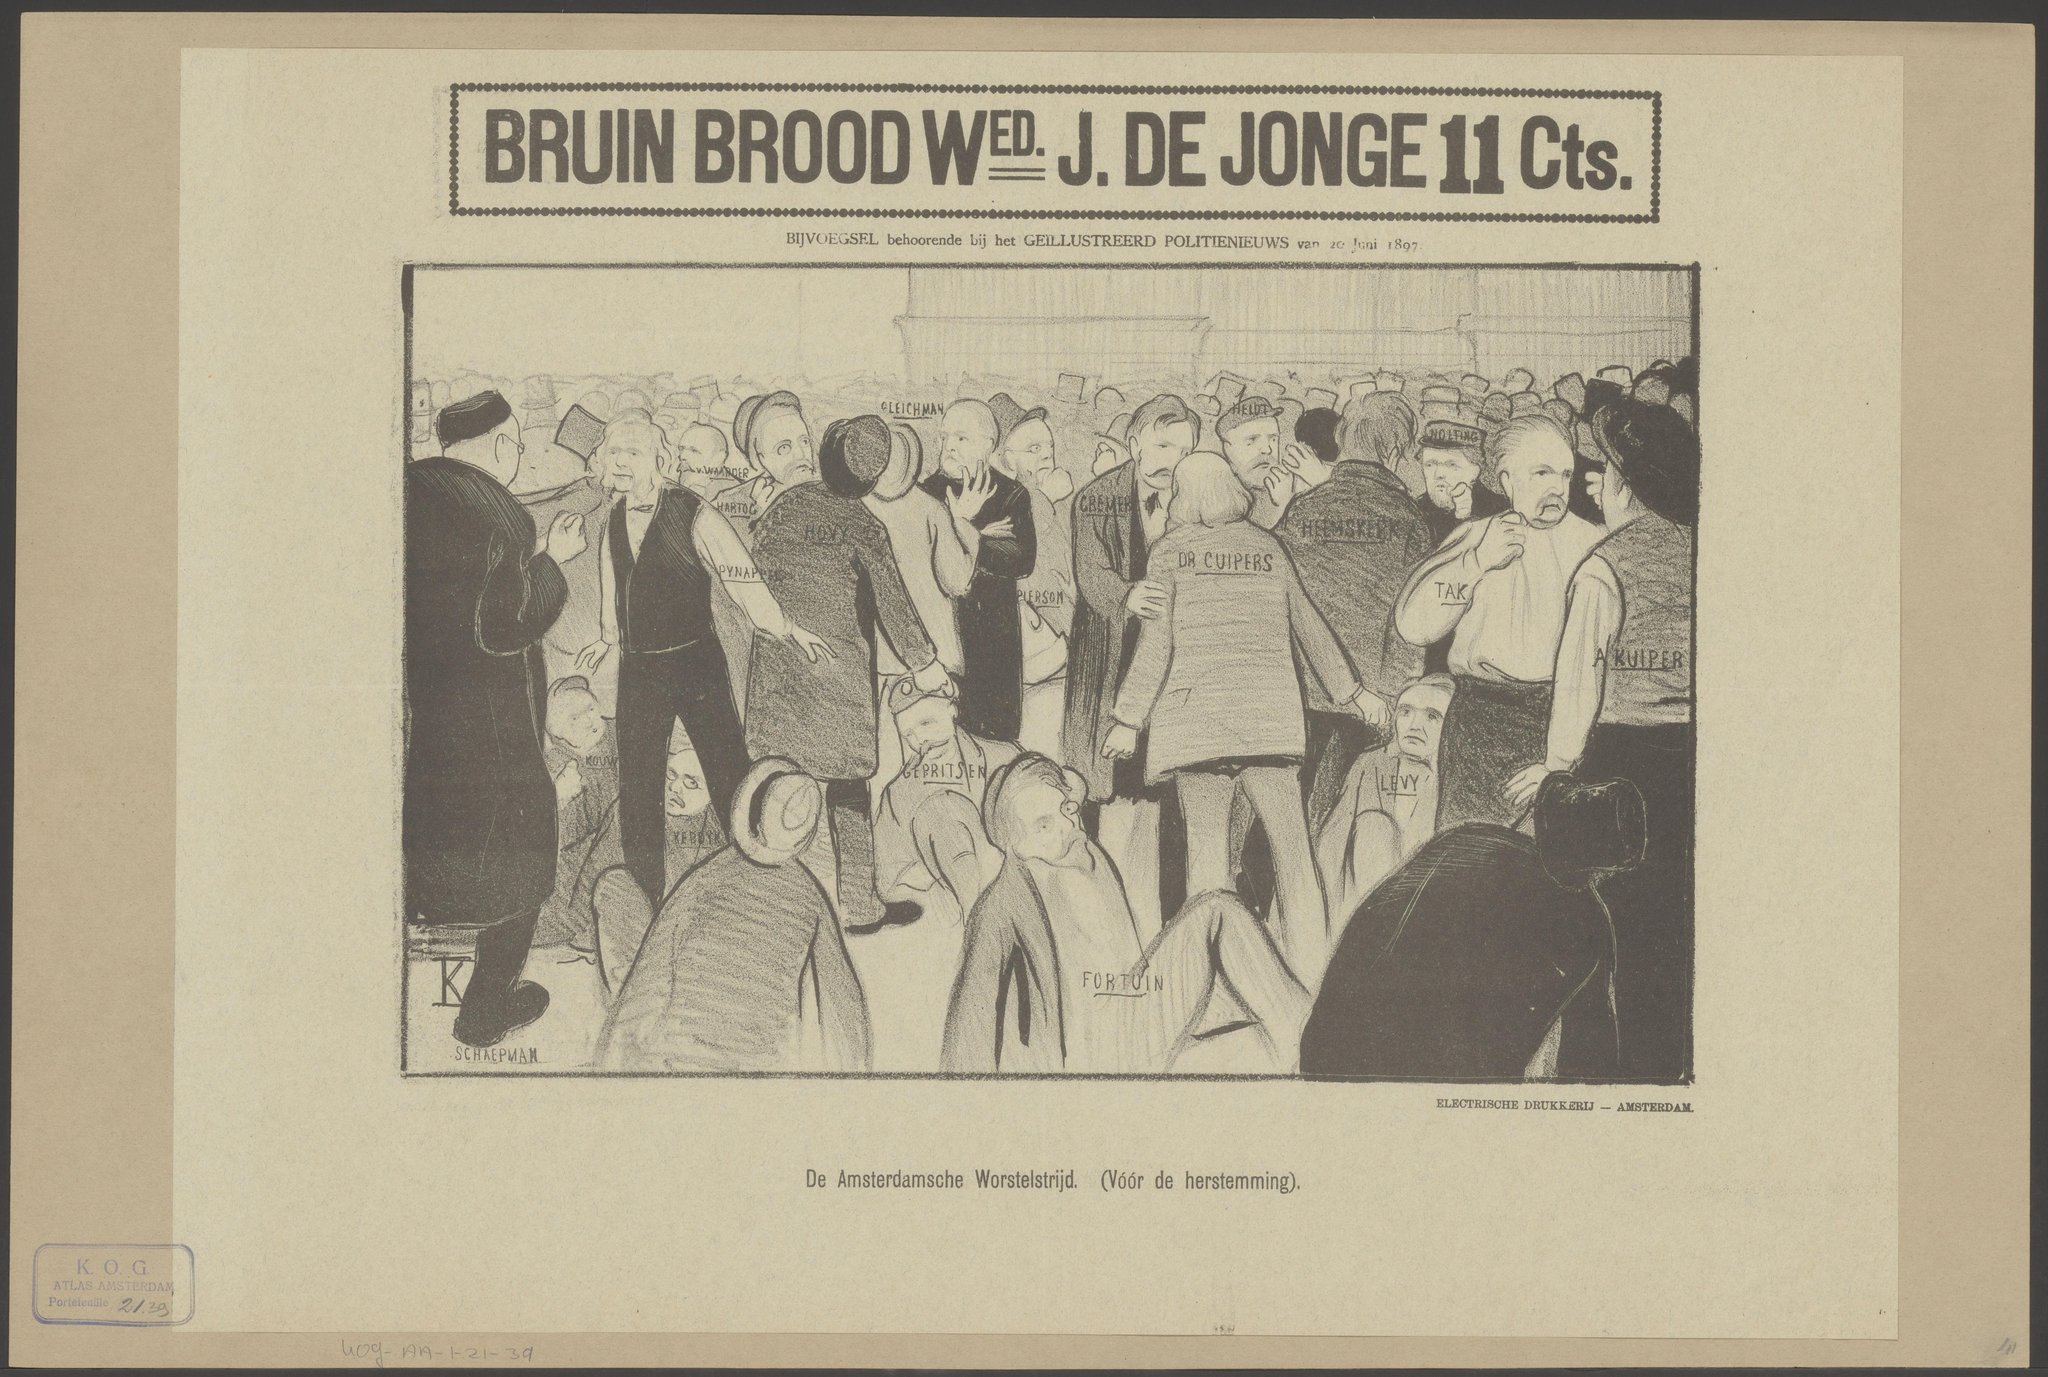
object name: cartoon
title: De Amsterdamsche Worstelwedstrijd / Vóór de herstemming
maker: Anonymous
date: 1897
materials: paper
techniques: letterpress printing, lithograph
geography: amsterdam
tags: nicolaas gerard pierson, the hague, abraham kuyper, utrecht, rome, priest, herman johannes aloysius maria schaepman, arnhem, amsterdam, politician, politician, e.g. party leader, political caricatures and satires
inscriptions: signature: ‘K (?)’, collector's mark: Lugt 1641b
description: Onderwerpsrubriek binnen de Atlas Amsterdam: Kiesverenigingen, Politieke partijen.